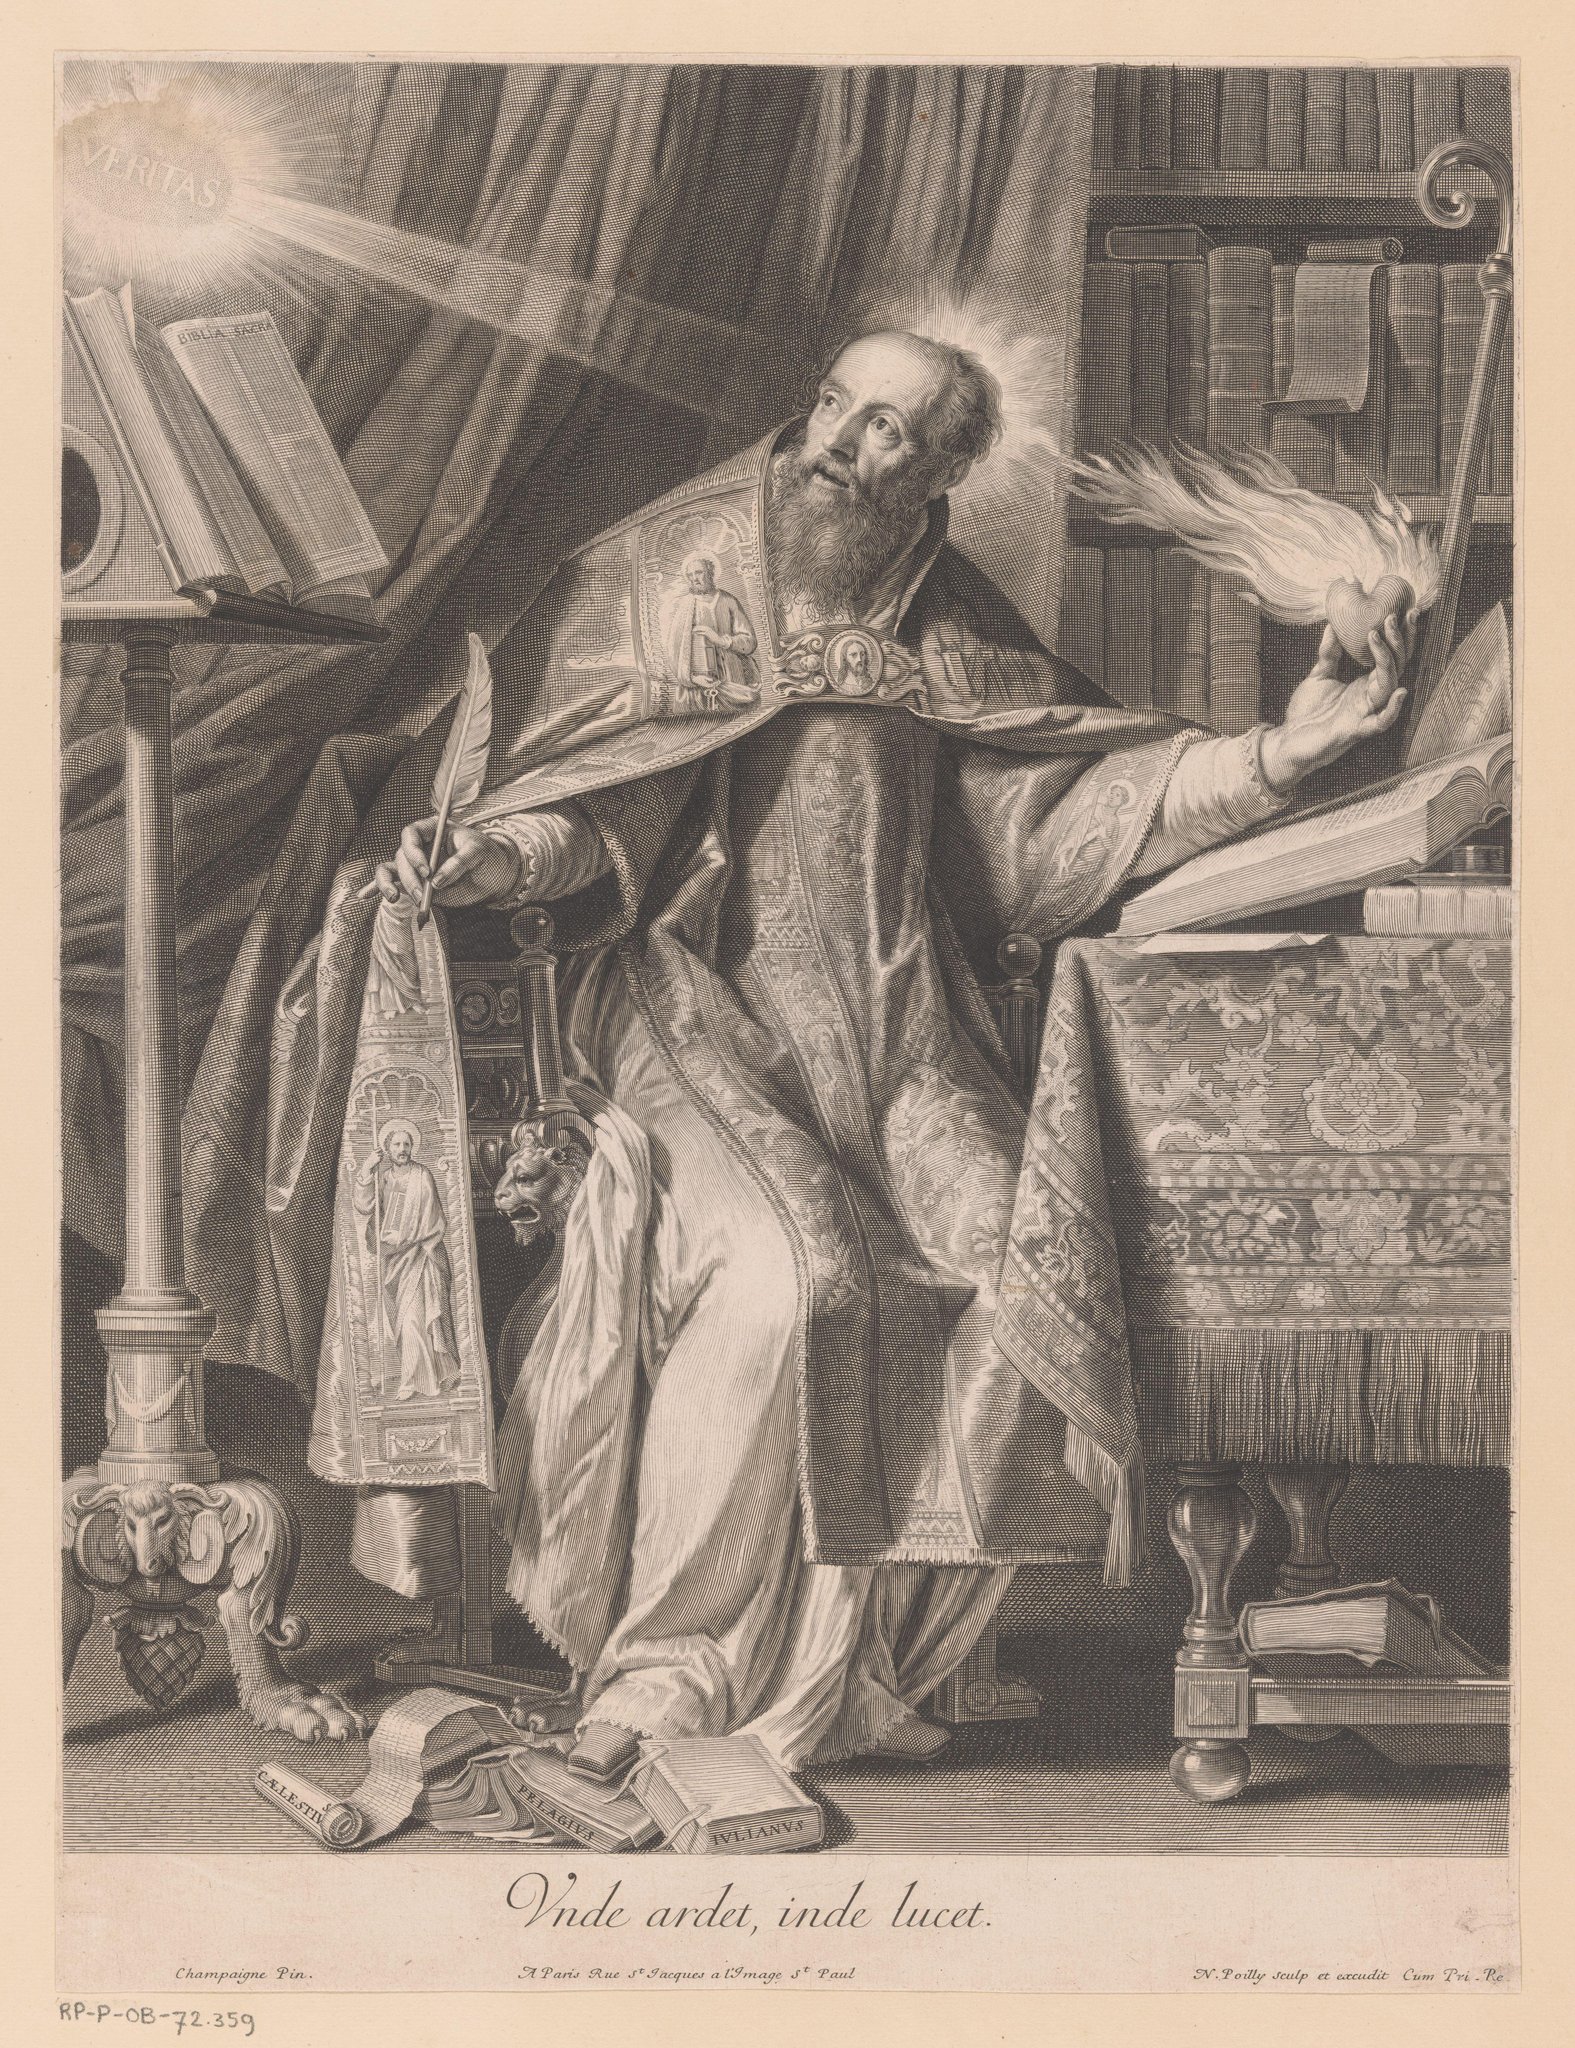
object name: print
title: Heilige Augustinus verlicht door Veritas, in zijn hand een brandend hart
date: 1636-1696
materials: paper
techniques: engraving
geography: france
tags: augustine, bishop of hippo; possible attributes: arrows piercing his breast, book, child with spoon, flaming heart, heart (pierced with arrows), pen